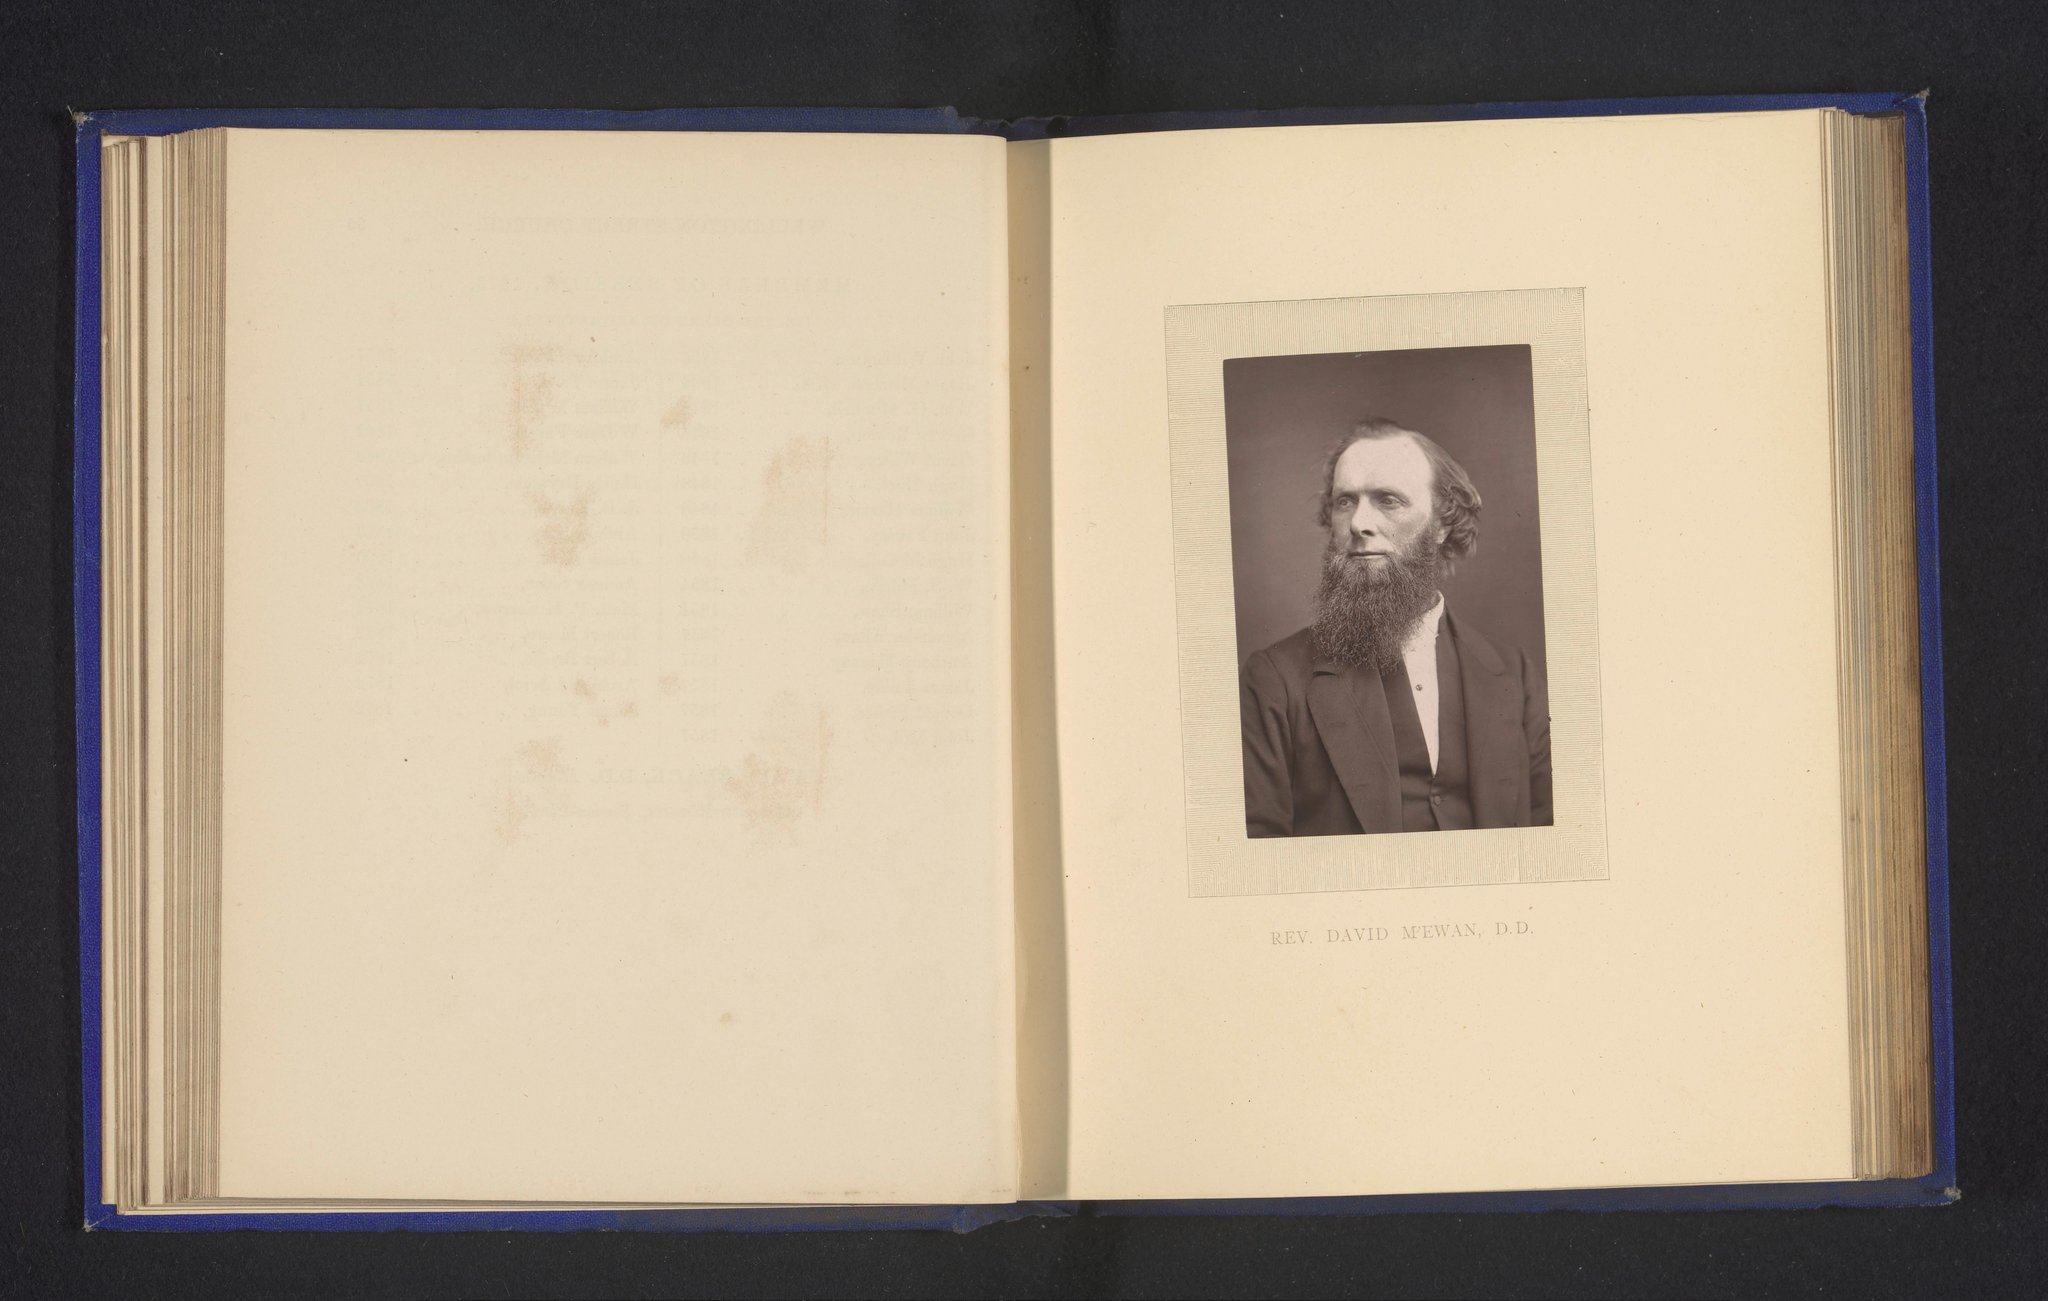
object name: photomechanical print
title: Portret van David McEwan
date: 1865-1875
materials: paper, photographic support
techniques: carbon print, woodburytype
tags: functionaries and dignitaries (with name) ~ protestant churches